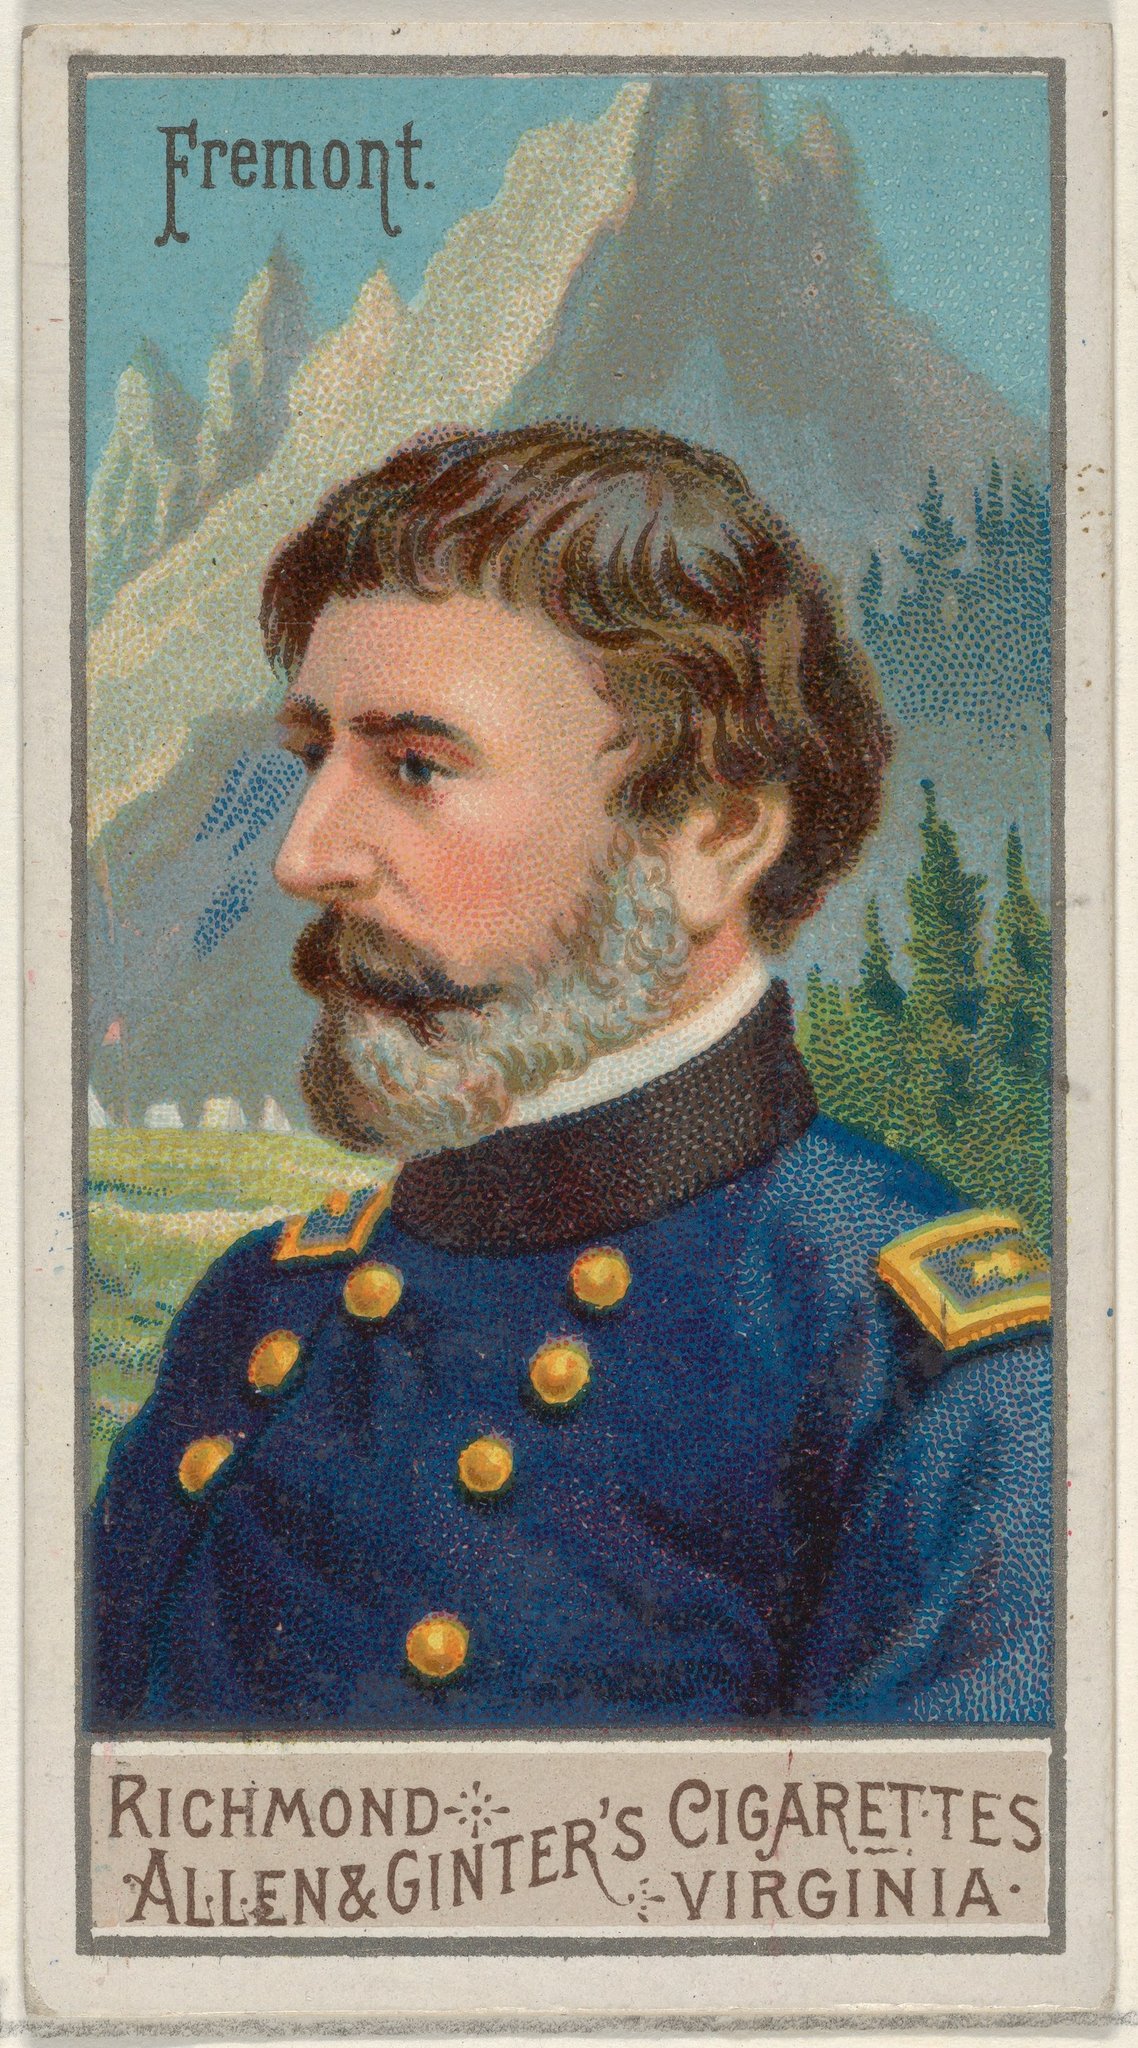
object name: print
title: John Charles Frémont, from the Great Generals series (N15) for Allen & Ginter Cigarettes Brands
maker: allen & ginter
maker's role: publisher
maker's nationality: american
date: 1888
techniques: color lithograph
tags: men,generals